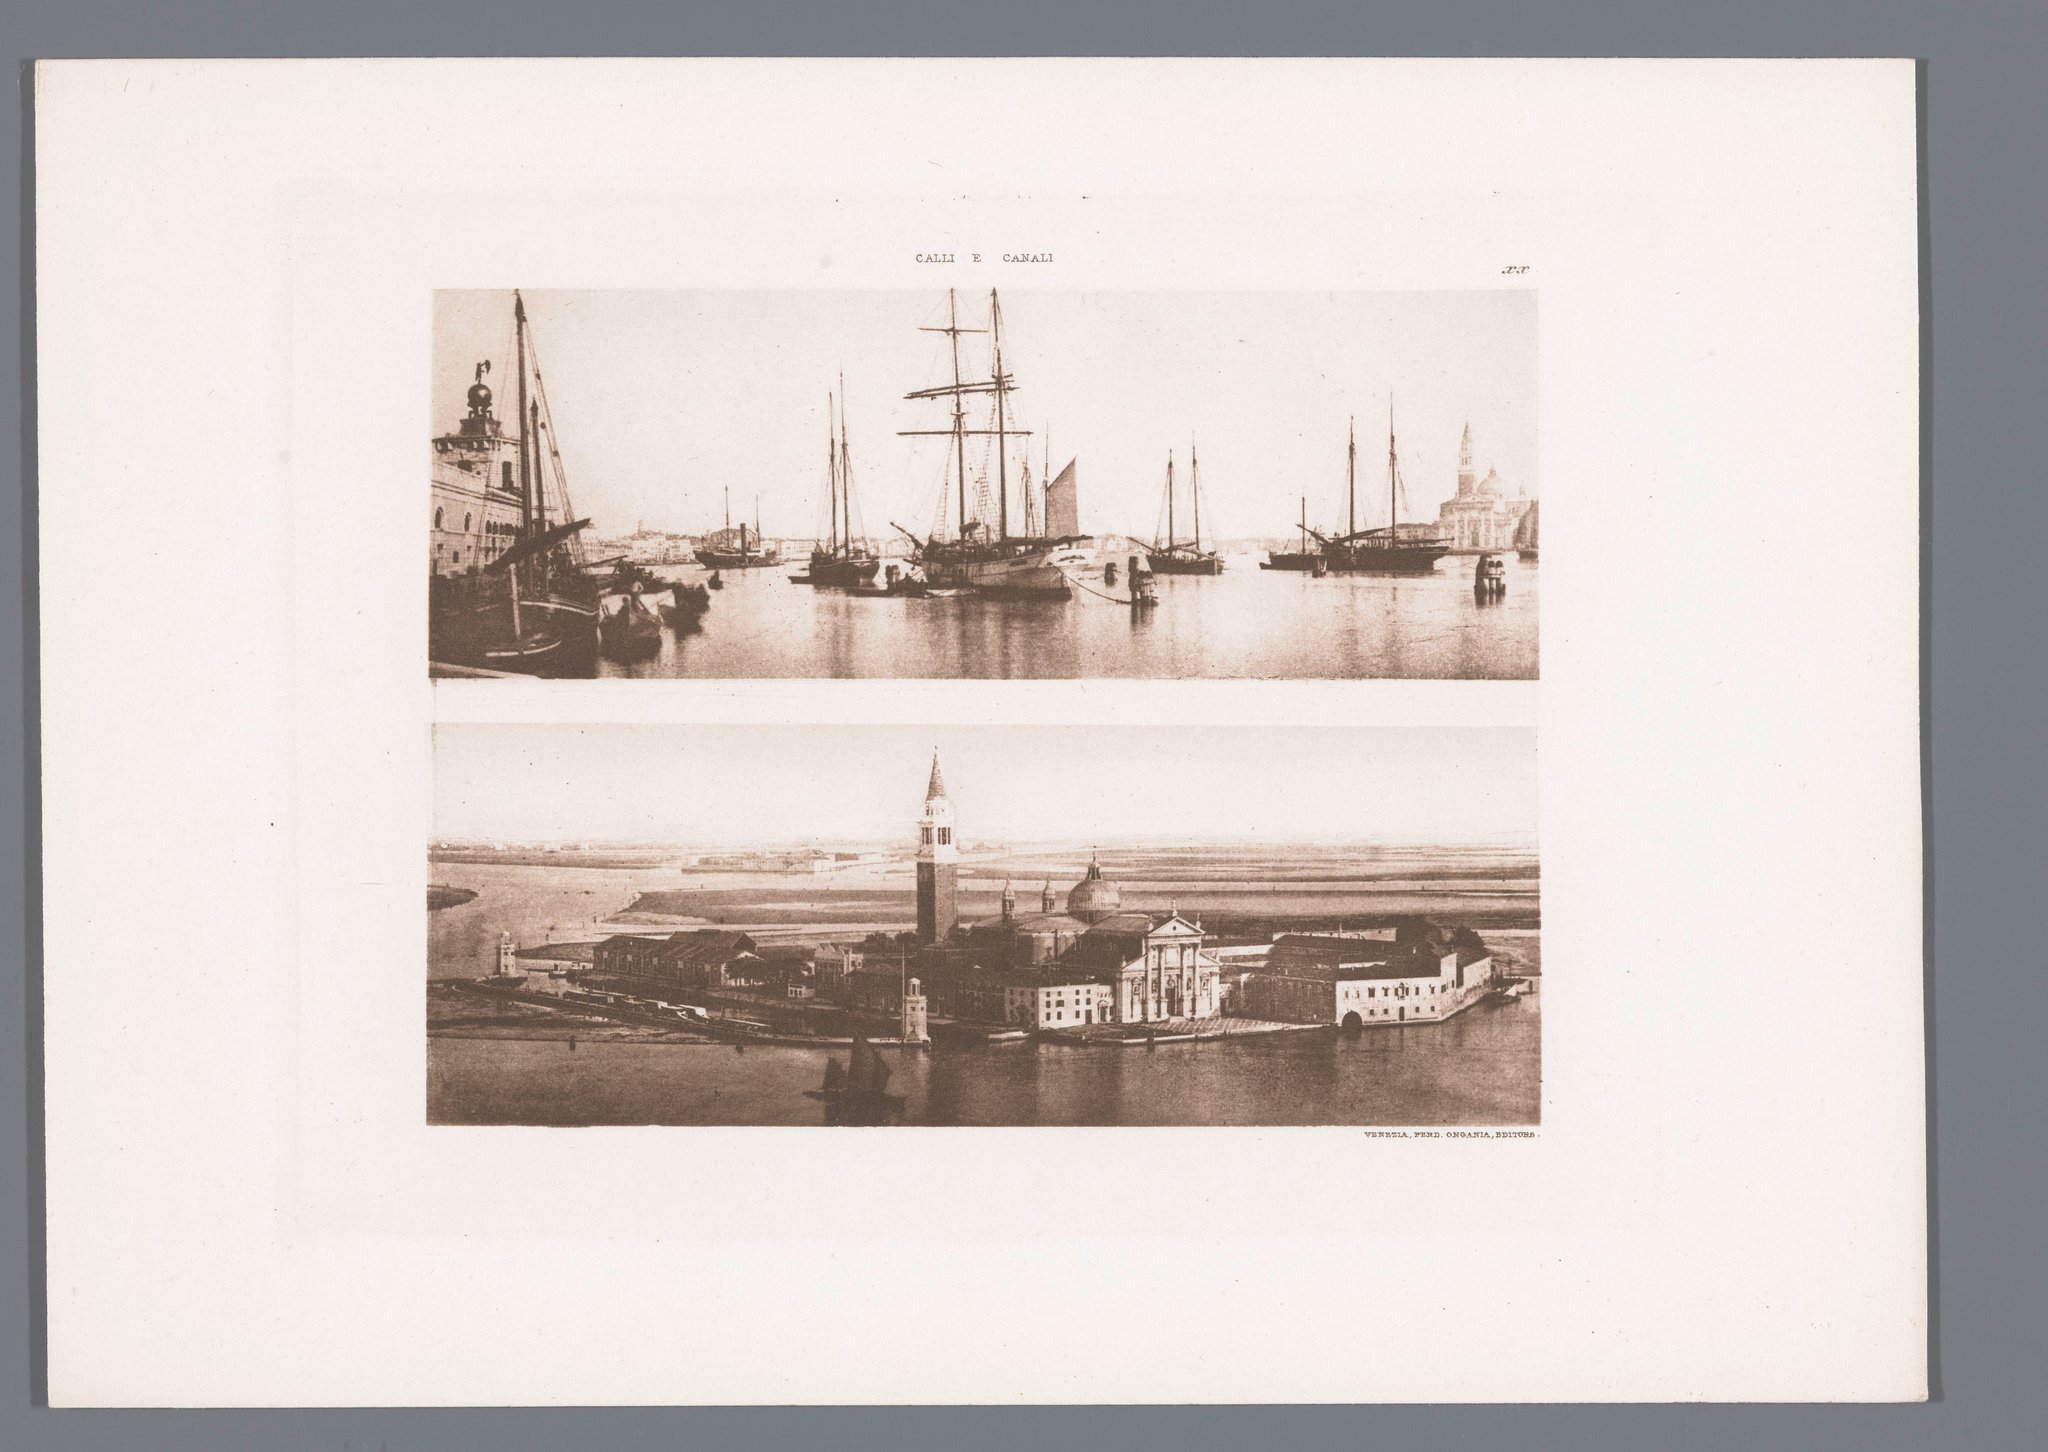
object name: photomechanical print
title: Calli e canali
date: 1888-1898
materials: paper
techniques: photoaquatint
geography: isola di san giorgio maggiore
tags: island, harbour (+ view ~ vehicle, ship, etc.), church (exterior)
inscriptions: inscription: ‘xx’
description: Boven: boten in een haven, onder: gezicht op het eiland met de Chiesa di San Giorgio Maggiore